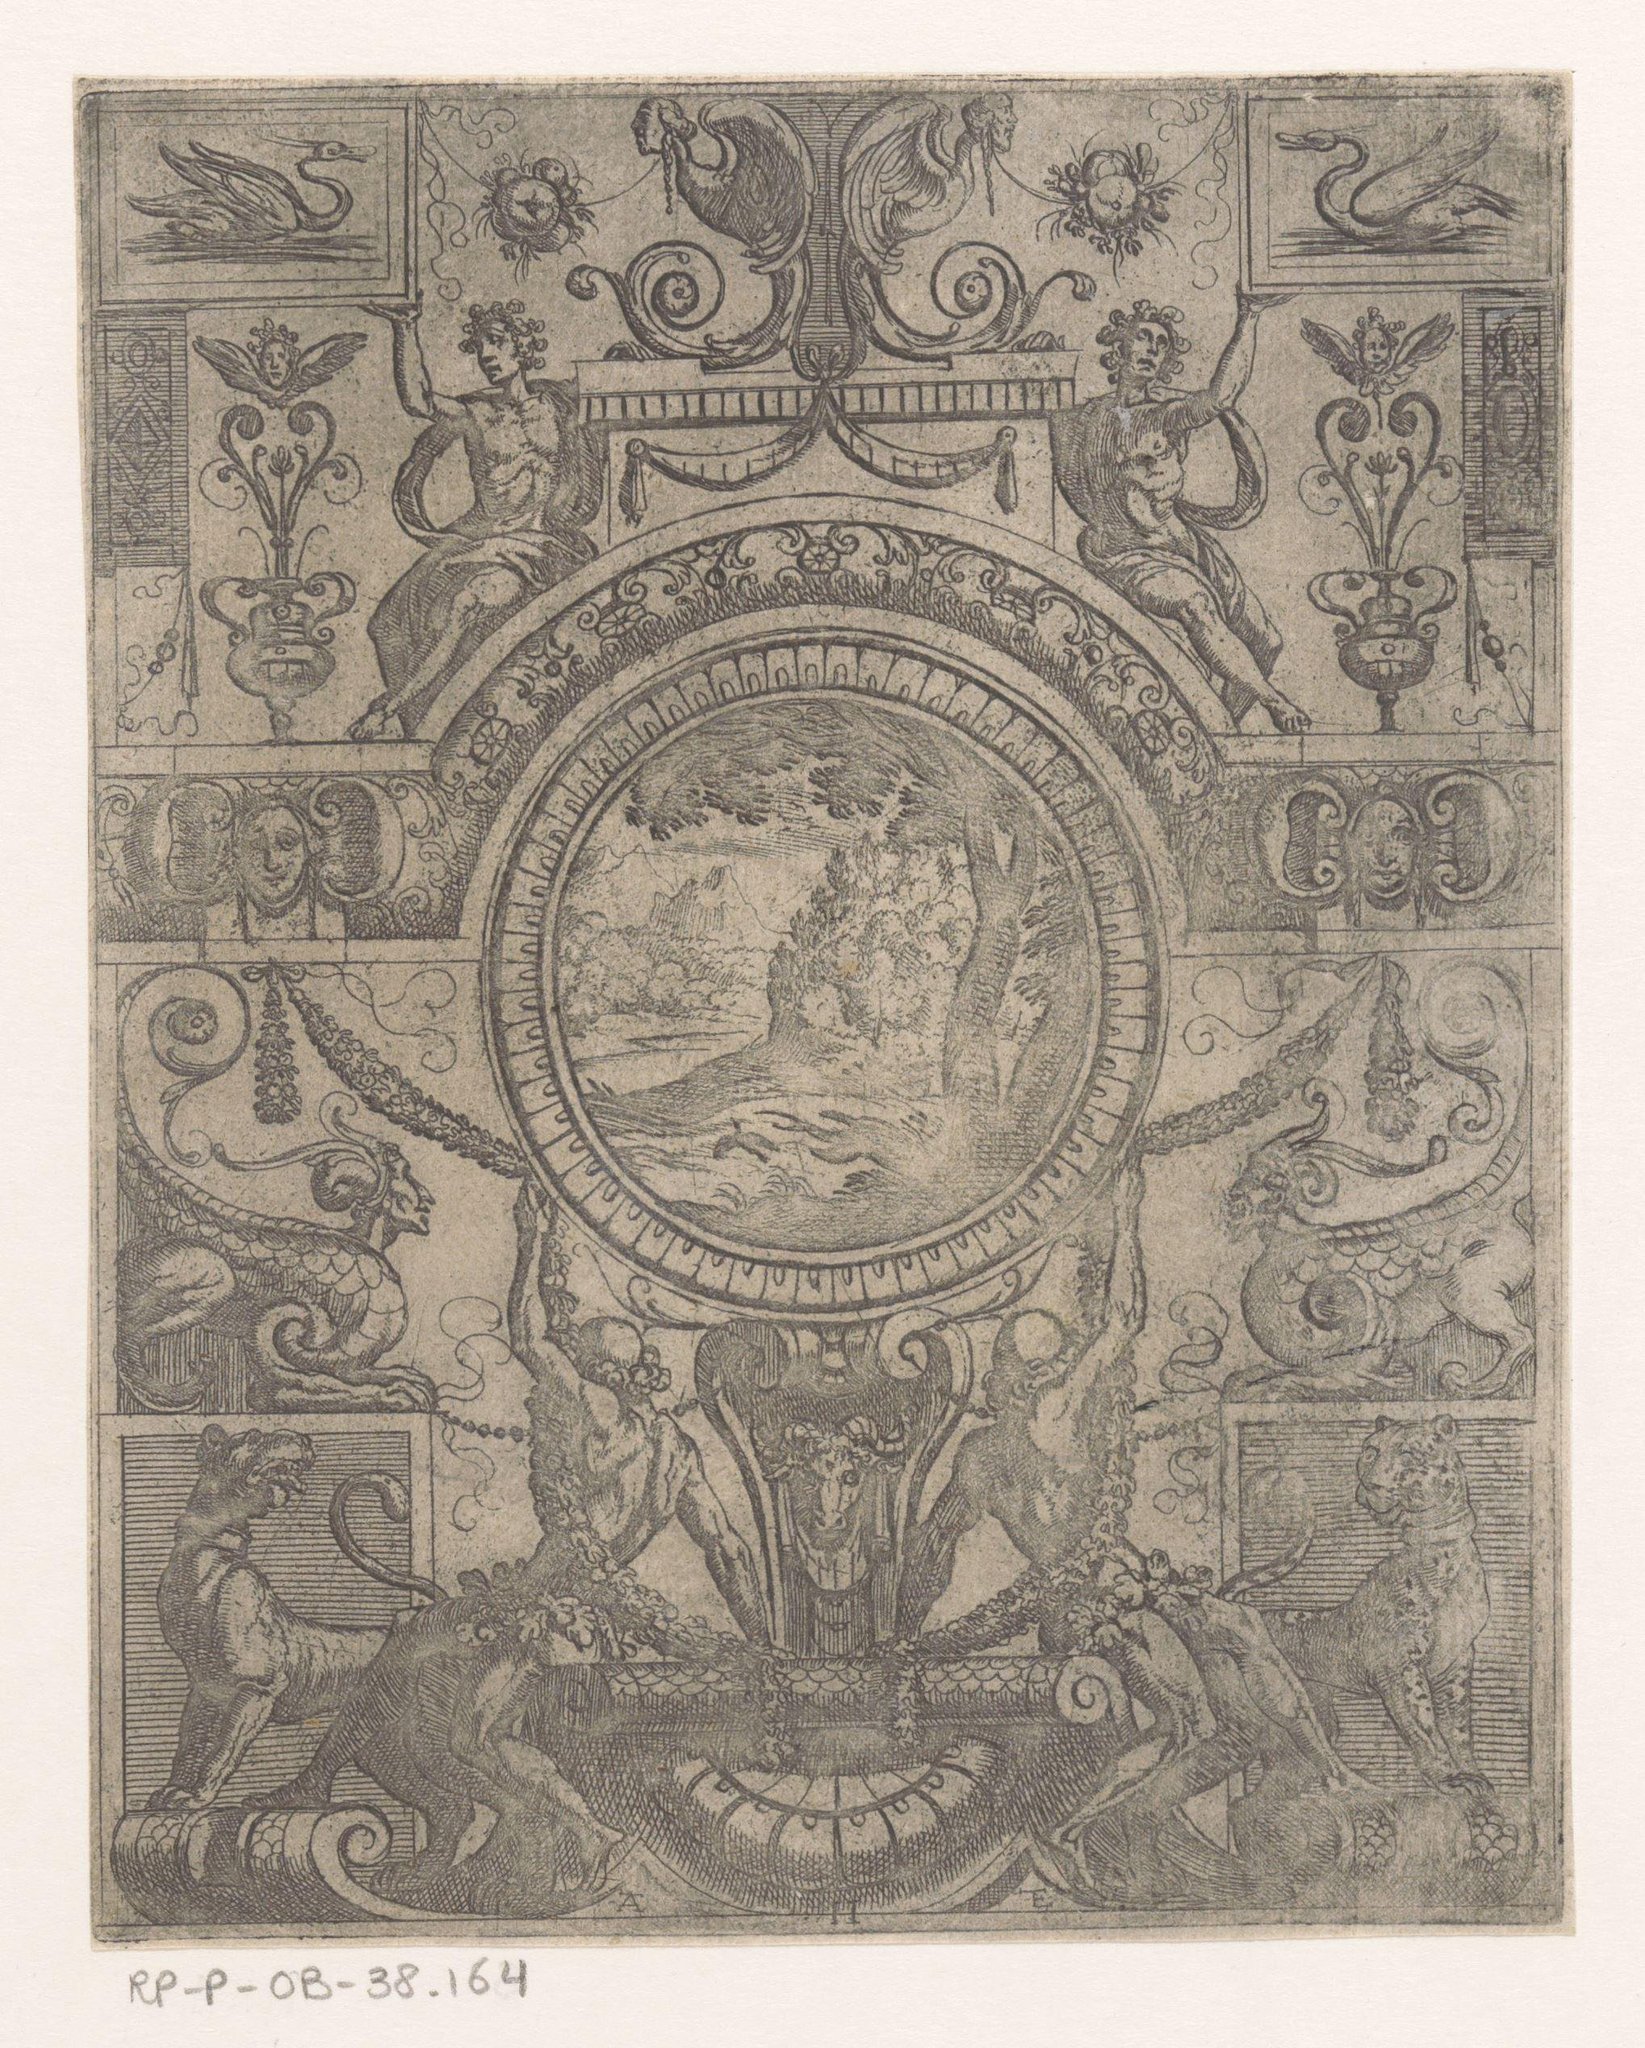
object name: print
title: Grotesk ornament met landschap in het midden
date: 1609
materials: paper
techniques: etching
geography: italy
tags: ornaments ~ art, landscapes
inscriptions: collector's mark: Lugt 240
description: Deze prent maakt deel uit van een reeks van tien prenten met groteske ornamenten.